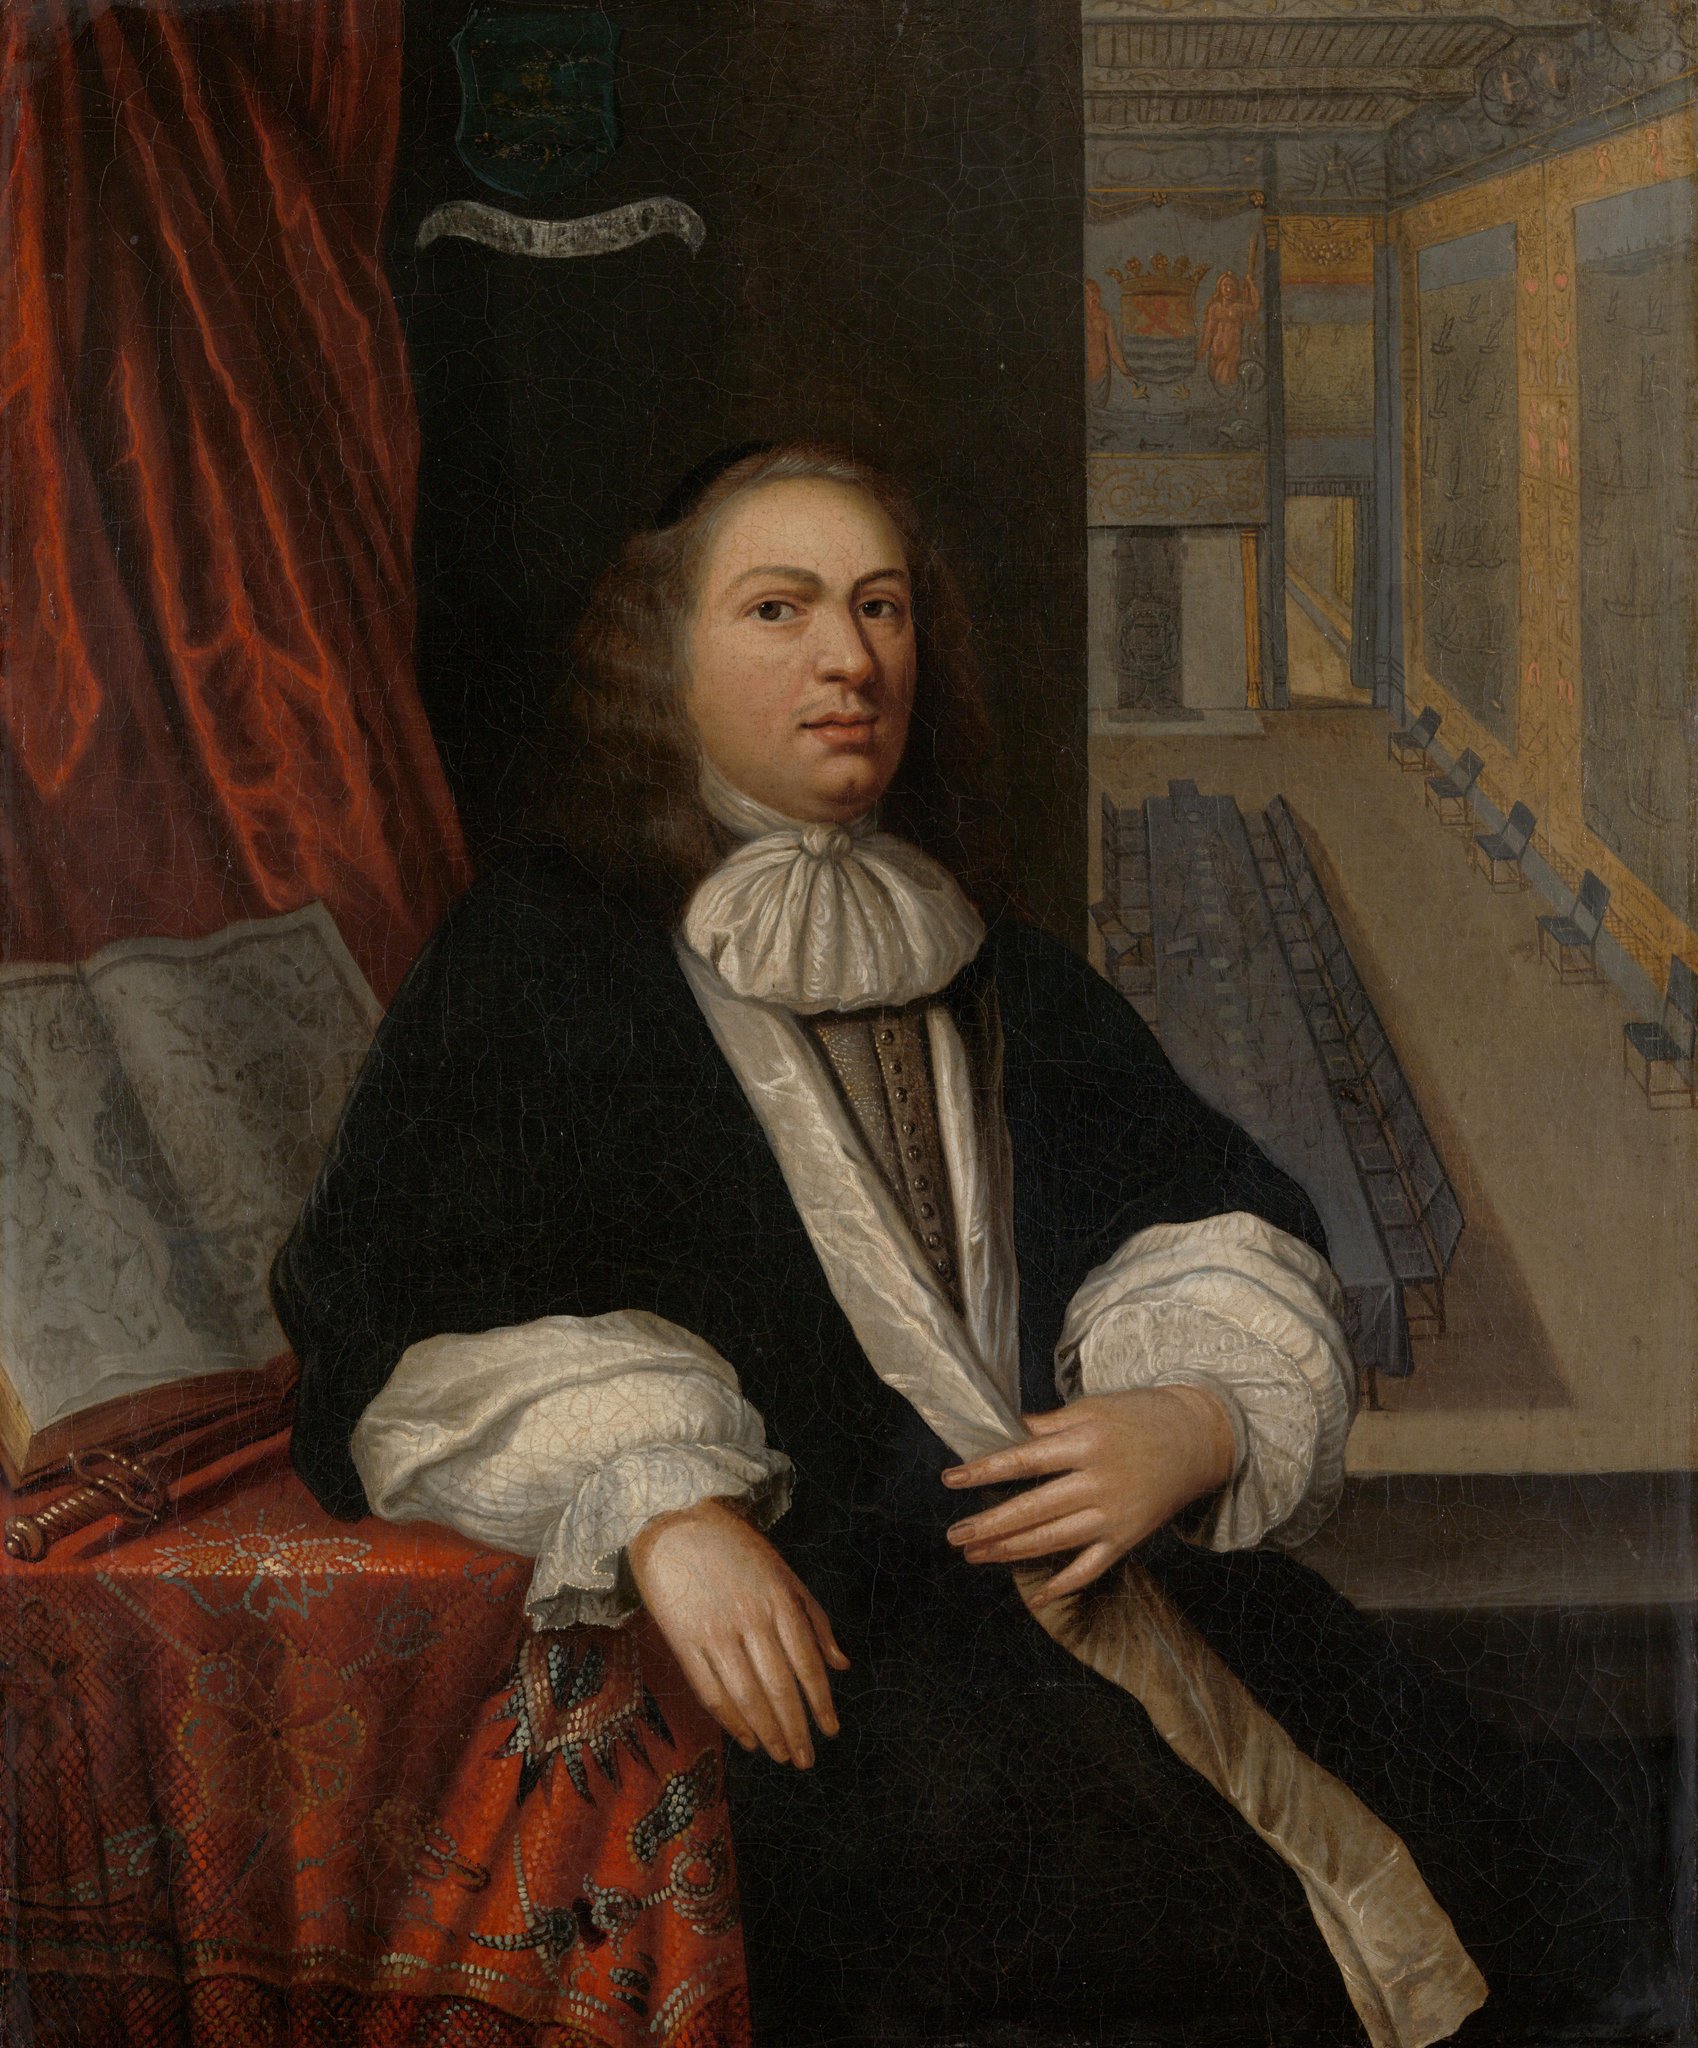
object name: painting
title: Portrait of Justus de Huybert, Clerk of the States of Zeeland and of the Admiralty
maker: Anonymous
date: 1665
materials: canvas, oil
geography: zeeland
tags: justus de huybert, zeeland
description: Justus de Huybert. Zeeland school, c. 1665. Justus de Huybert (1610-1682) was secretary of the States of Zeeland. The same function he held with the Zeeland Admiralty. Like many prominent contemporaries, Huybert had his portrait painted wearing a Japanese gown, and on his head a skullcap. In the background: the assembly hall of the States of Zeeland in the Abbey of Middelburg.